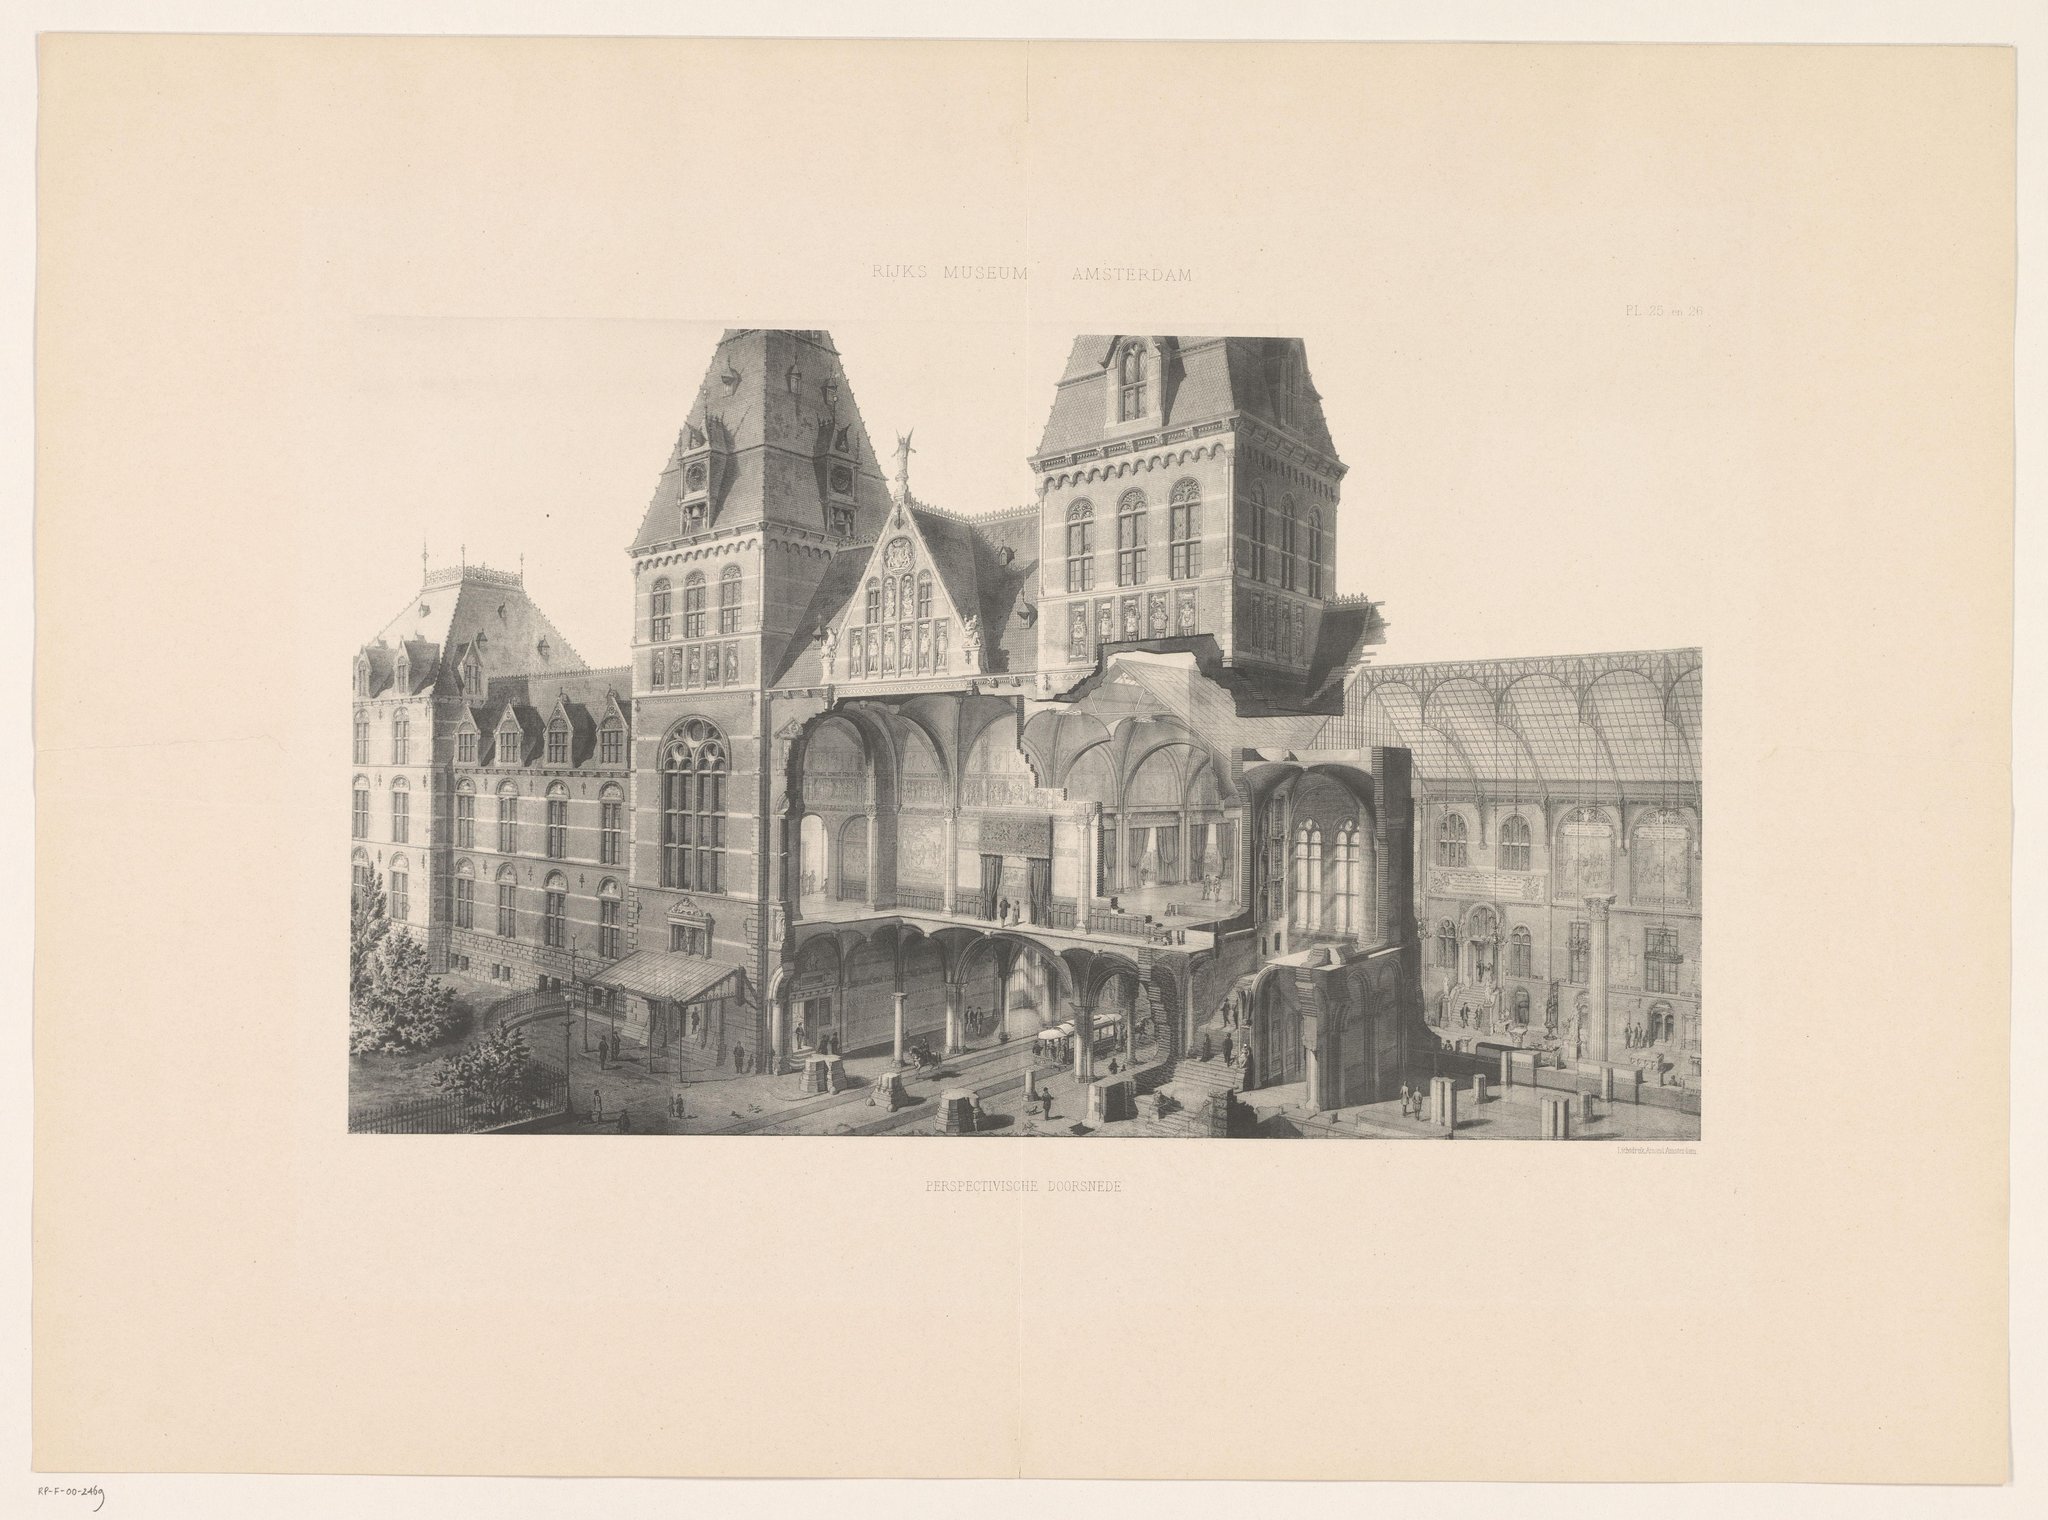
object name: photograph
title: Perspectivische doorsnede van het Rijksmuseum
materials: paper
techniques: photograph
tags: permanent exhibition, museum